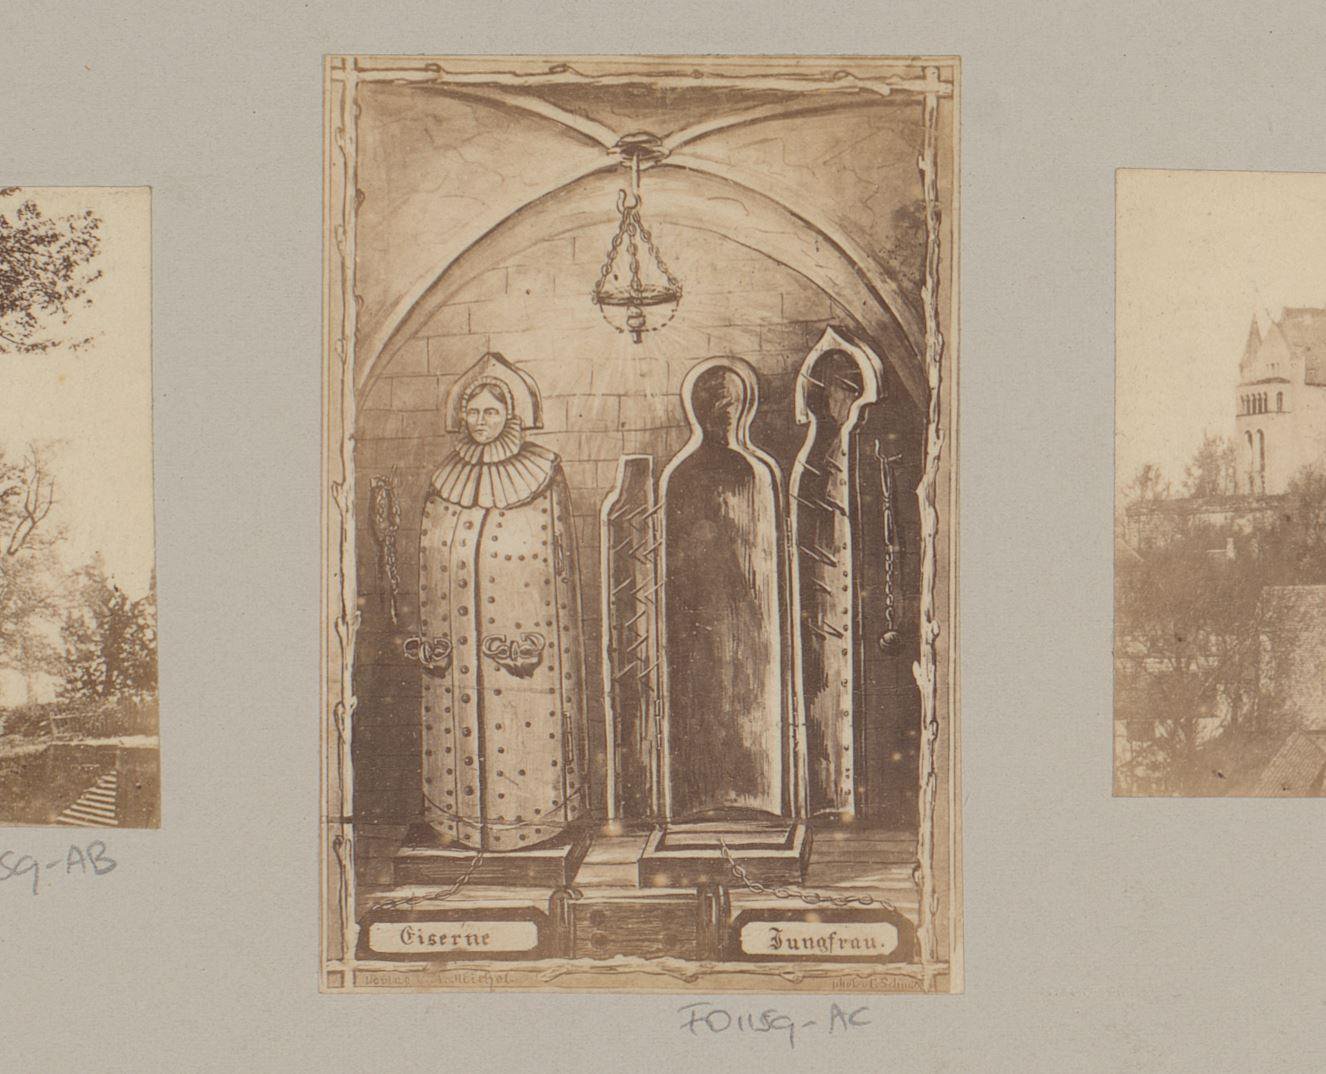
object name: photograph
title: Fotoreproductie van vermoedelijk een tekening van de ijzeren maagd van Neurenberg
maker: Anonymous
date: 1880-1900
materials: photographic support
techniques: albumen print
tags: torture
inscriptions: inscription: ‘Eiserne Jungfrau. Verlag [...] A. Michel phot. [...] Schm[...]’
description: Onderdeel van Reisalbum met opnames van bezienswaardigheden in Zweden, Noorwegen, Denemarken, Beieren, Milaan en Parijs.